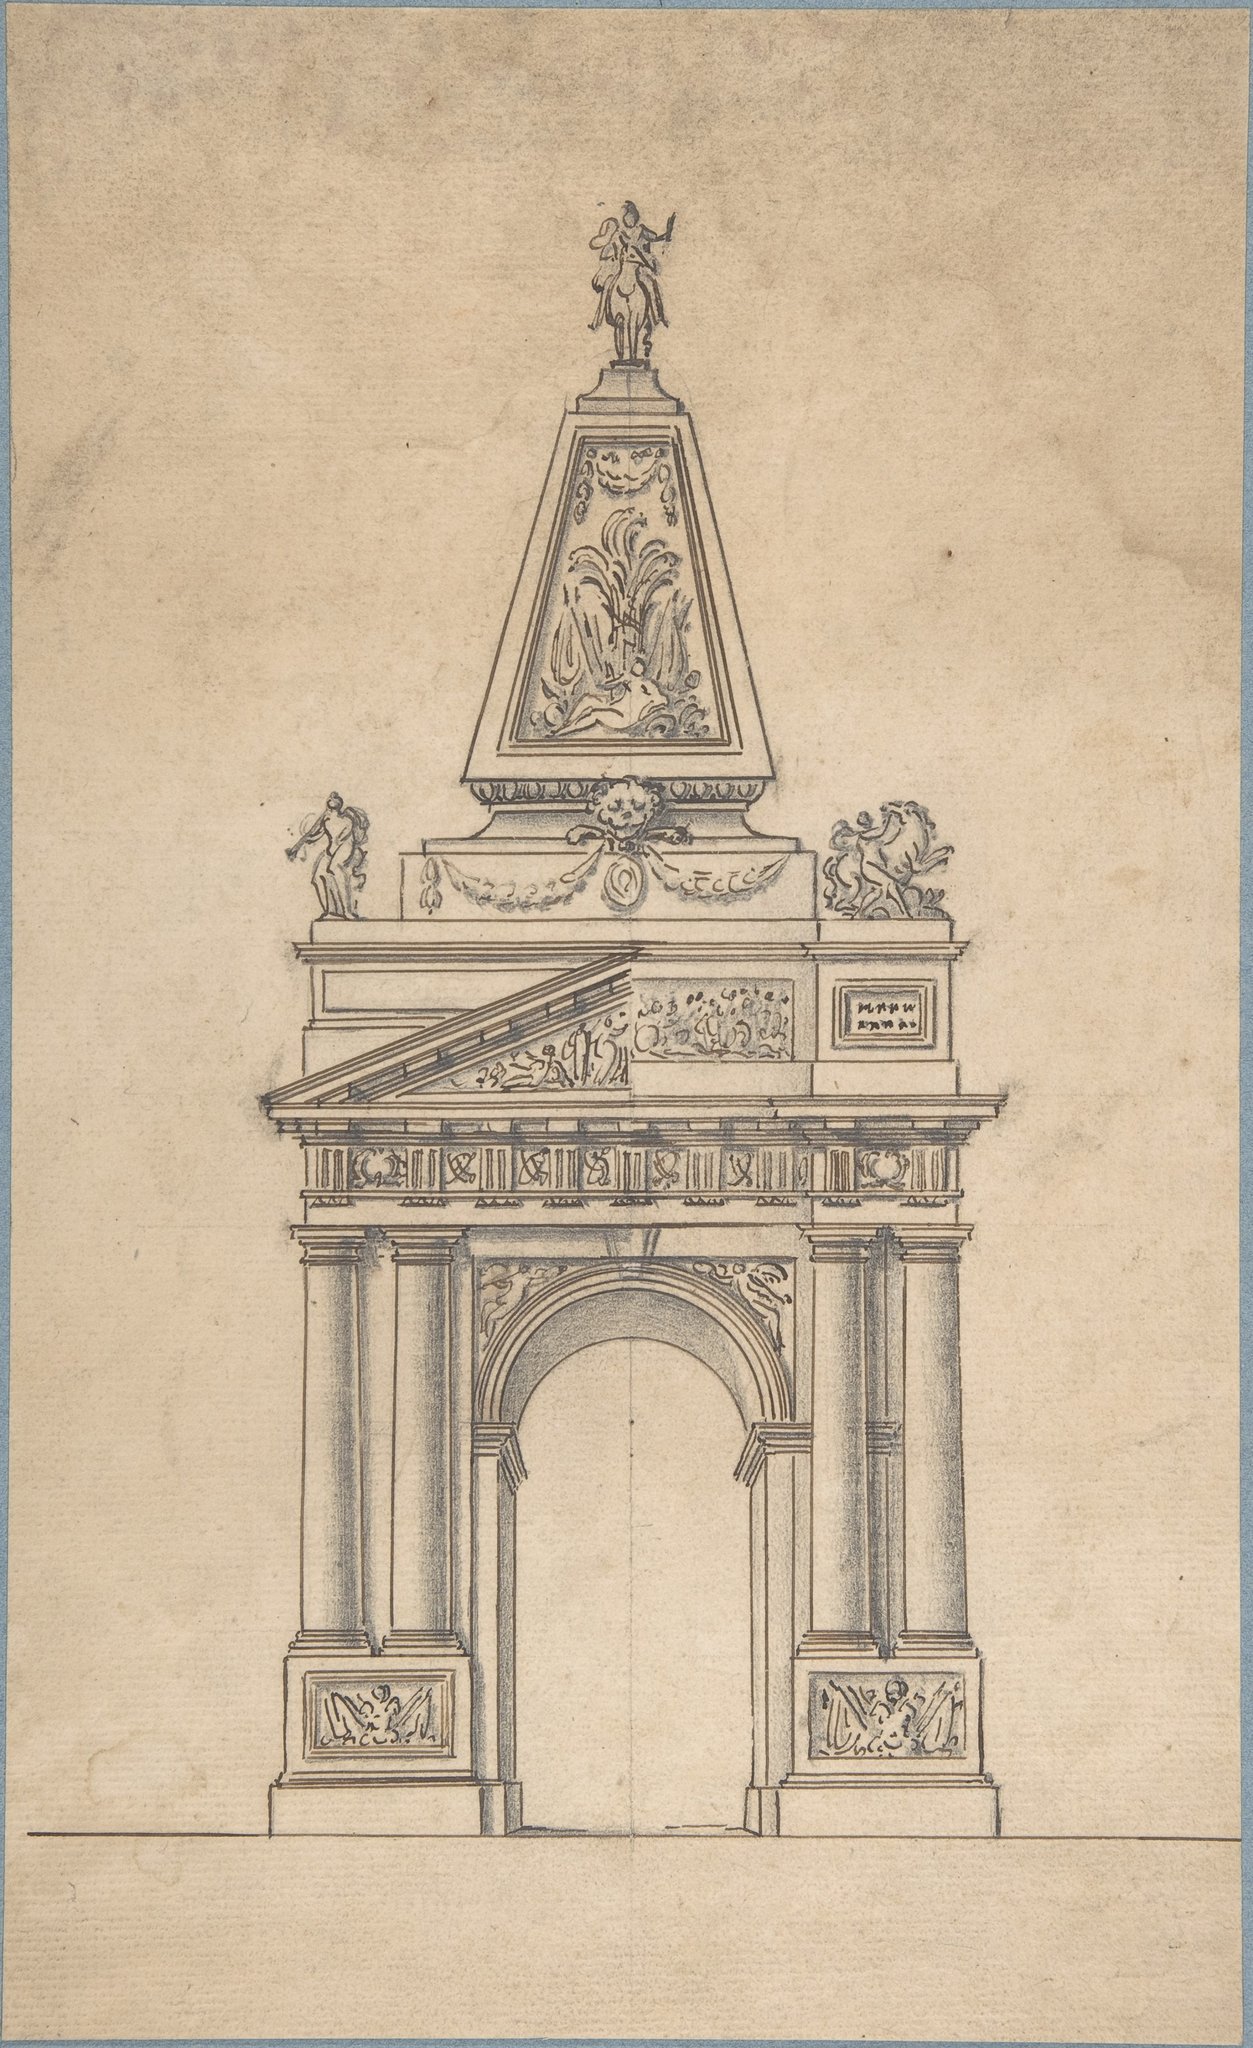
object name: drawing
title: Design for a Triumphal Arch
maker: anonymous, french, 18th century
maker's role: artist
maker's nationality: french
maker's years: 1700-1800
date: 1767-1833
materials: graphite, ink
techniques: pen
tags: arches